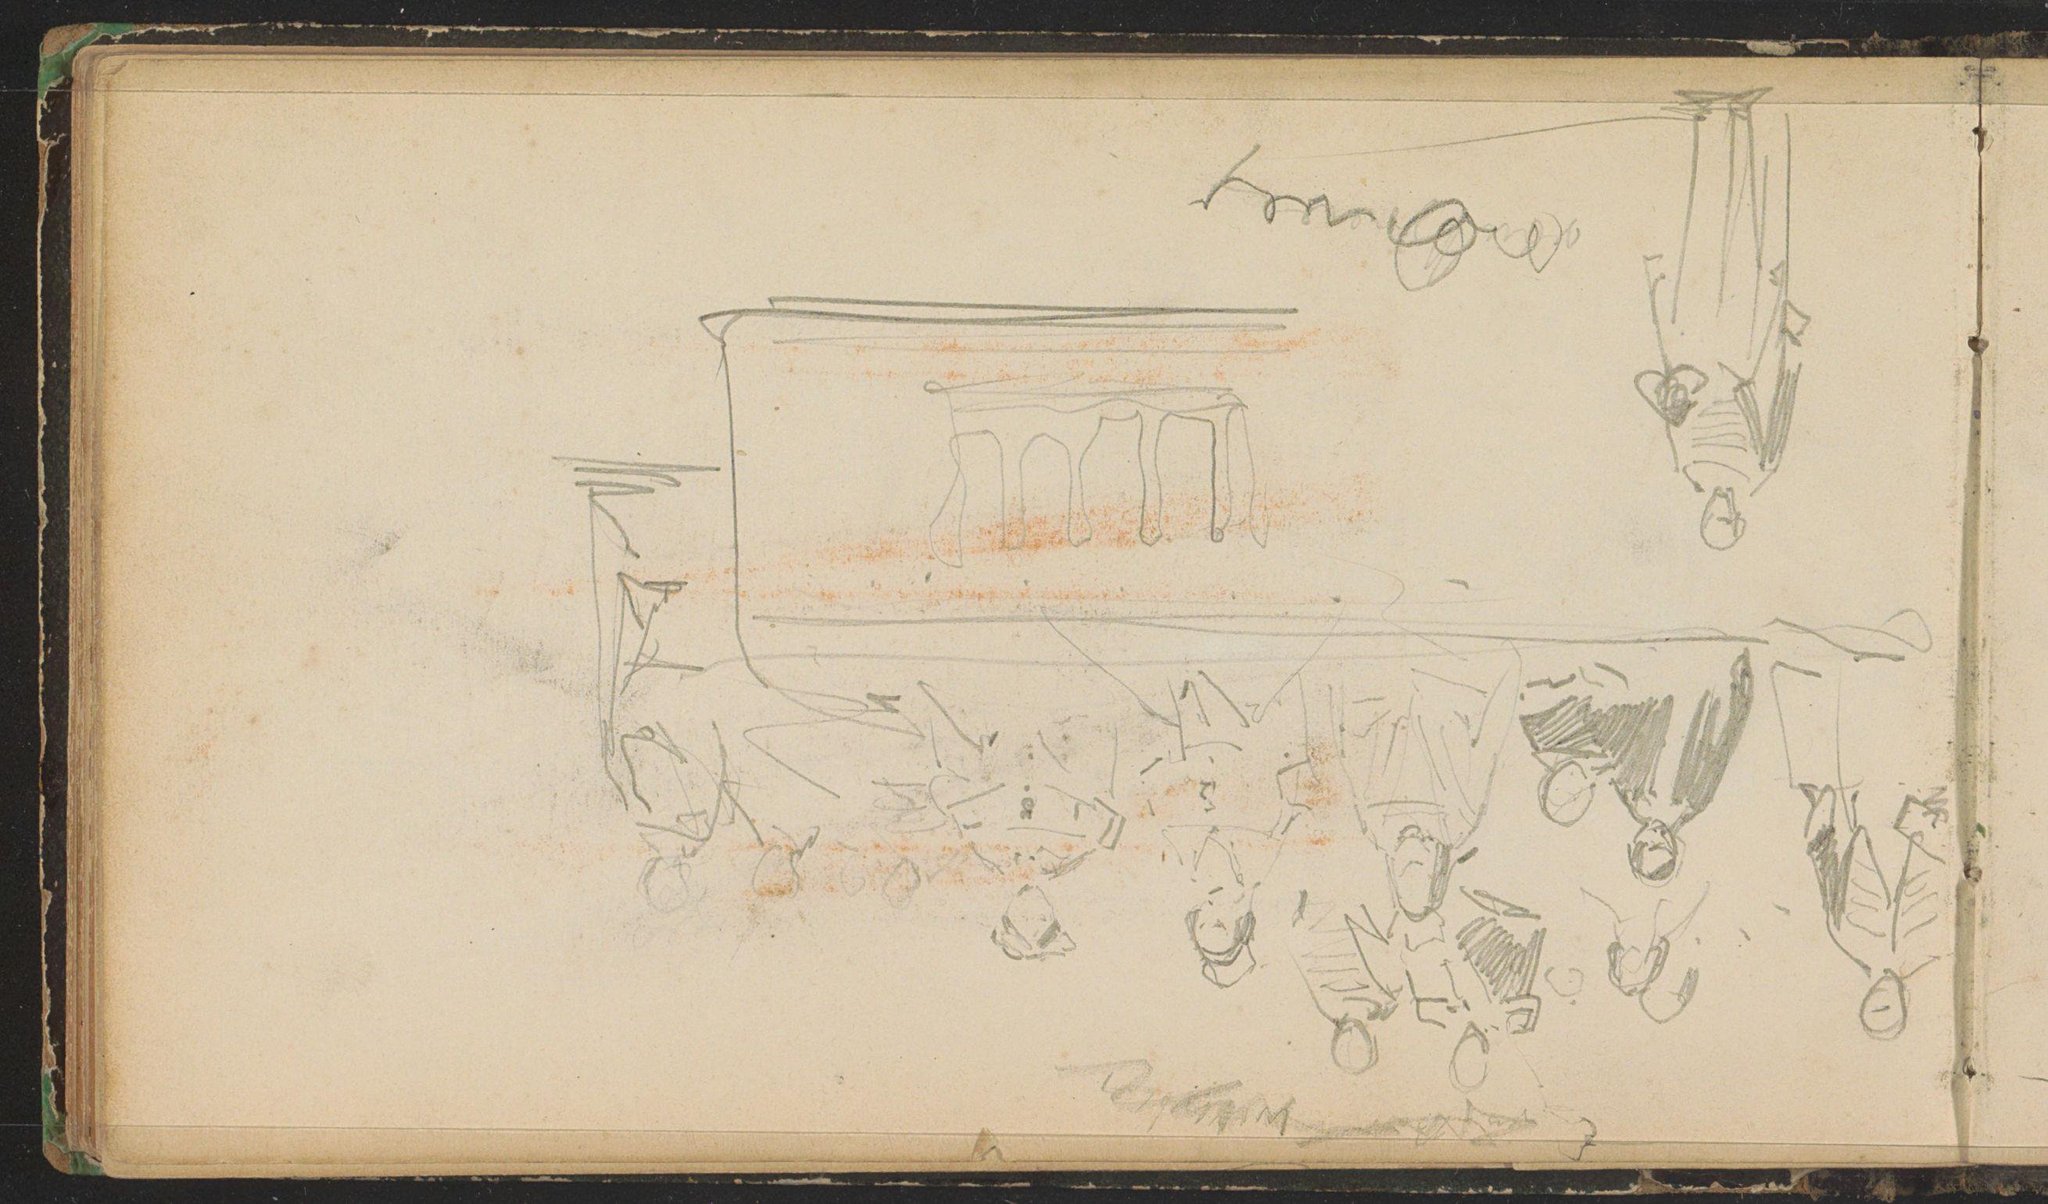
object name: sketchbook leaf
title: Figuren in avondkleding zittend aan een tafel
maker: johannes bosboom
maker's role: draughtsman, painter, print maker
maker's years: 1817-1891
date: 1845-1891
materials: paper, pencil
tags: lackey and other lower personnel at court, celebration meal, feast, banquet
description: Vermoedelijk een banket. Naast de tafel staat een lakei. Blad 43 verso uit een schetsboek met 46 bladen.